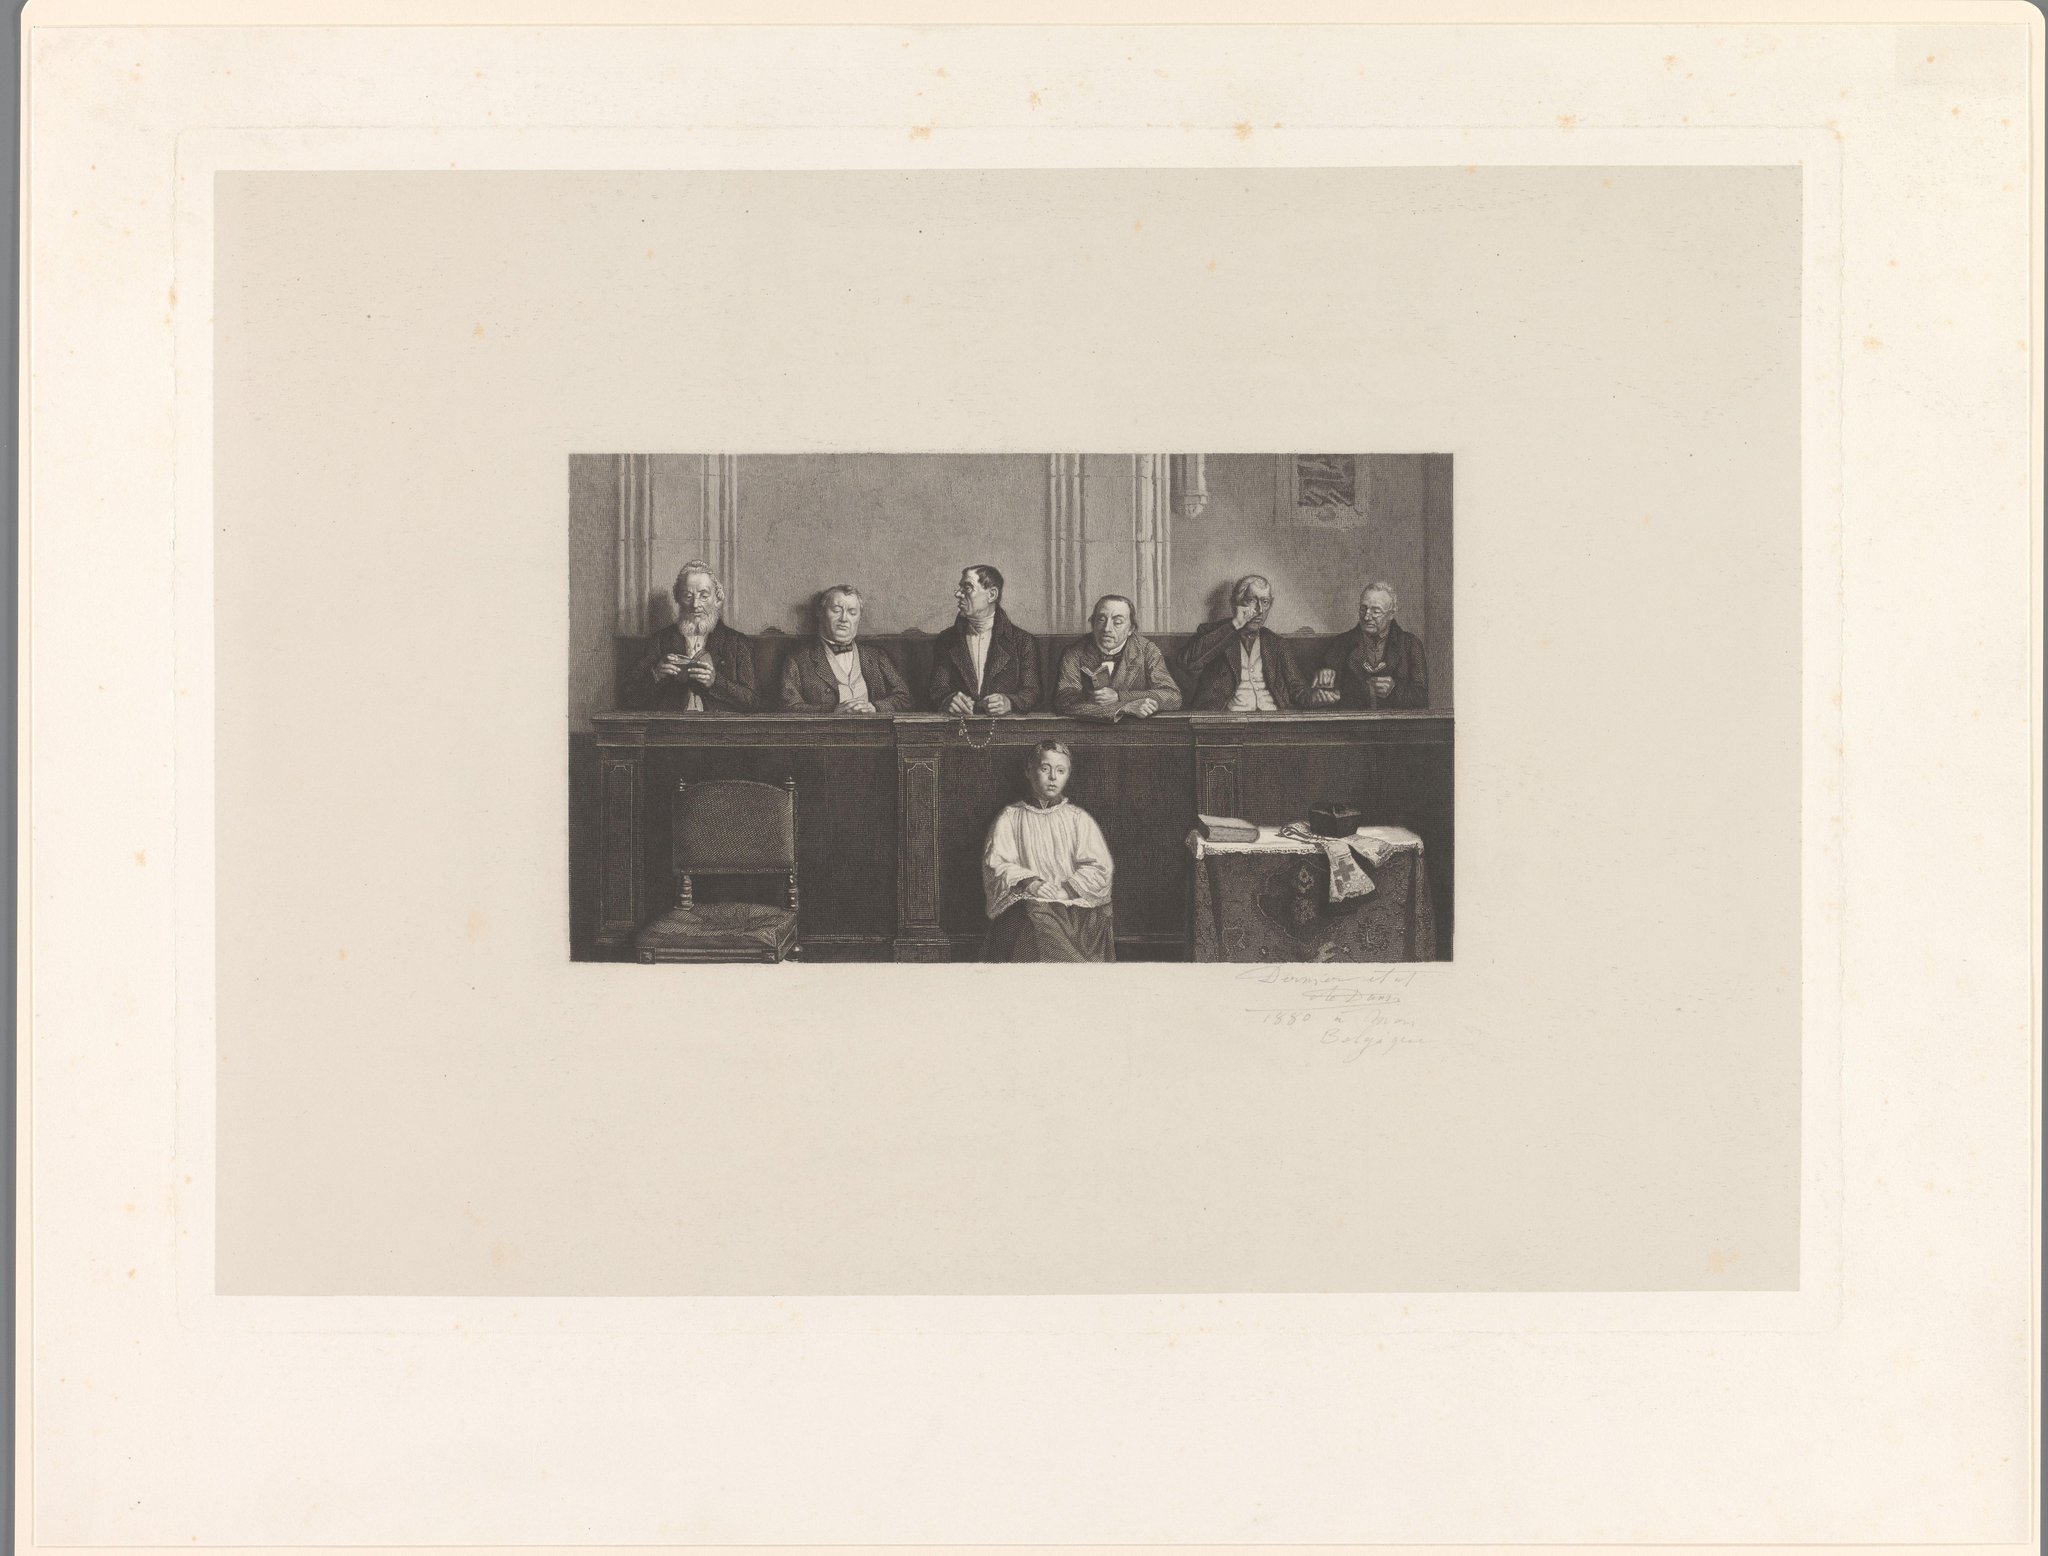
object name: print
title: Kerkgangers en een misdienaar in de kerk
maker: auguste danse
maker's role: print maker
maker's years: 1829-1929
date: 1880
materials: paper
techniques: etching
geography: bergen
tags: the congregation, holy mass (divine service, especially of roman catholic church)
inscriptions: annotation: ‘Dernier etat’, collector's mark: Lugt 2228